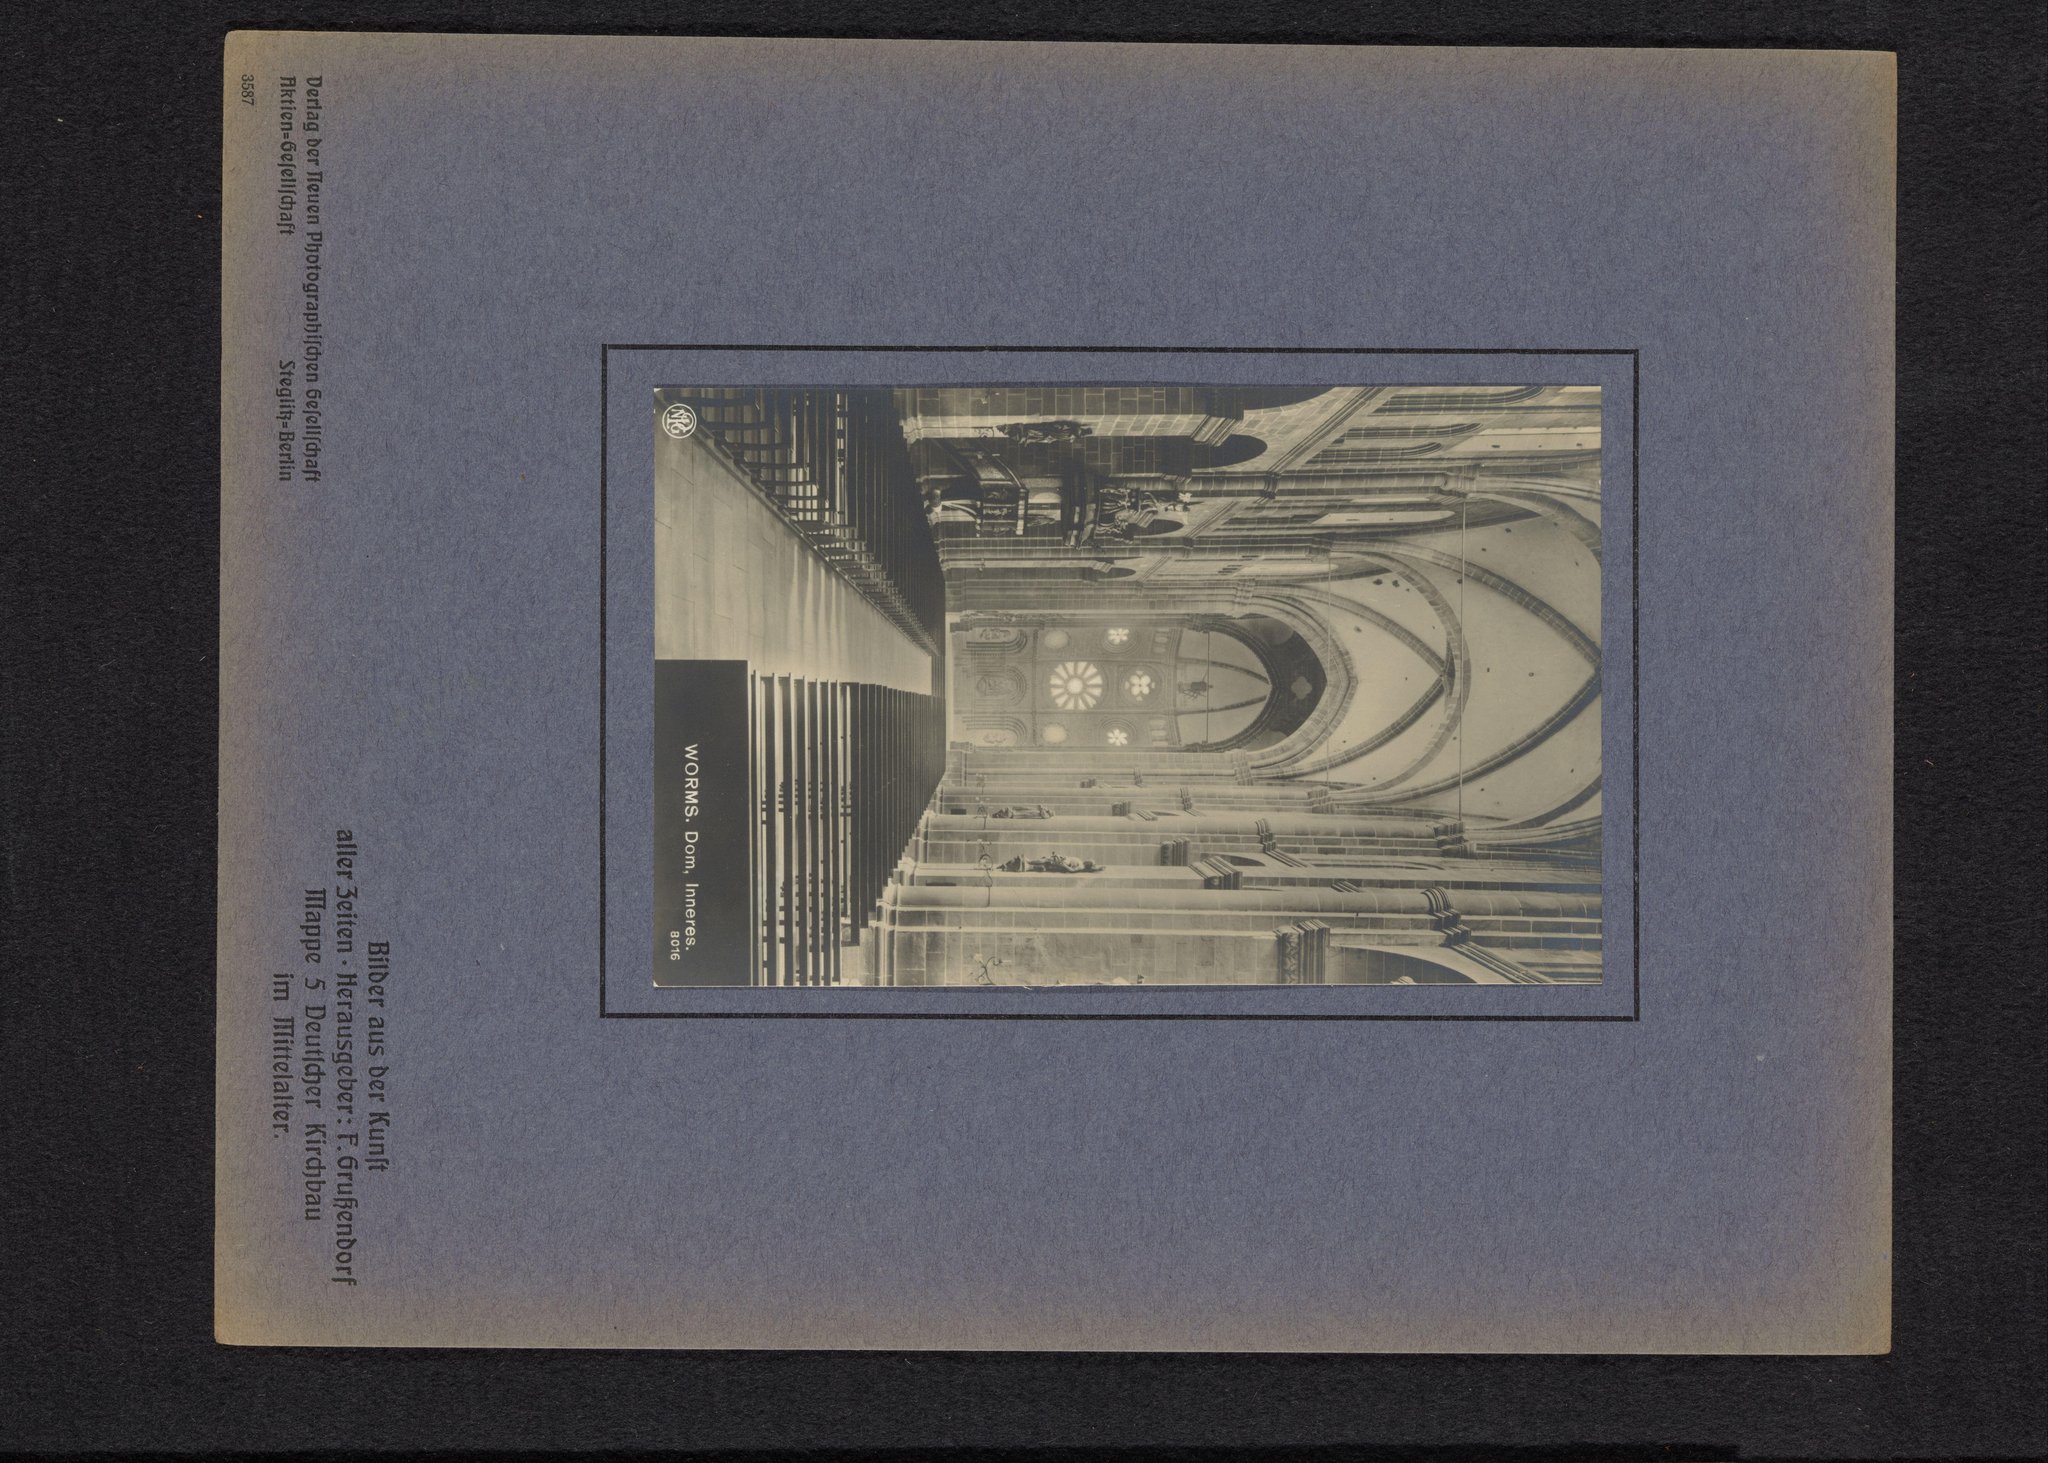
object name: photograph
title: Interieur van de dom van Worms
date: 1900-1911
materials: cardboard, photographic support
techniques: gelatin silver print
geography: worms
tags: interior of church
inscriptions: number: ‘3587’, number: ‘8016’